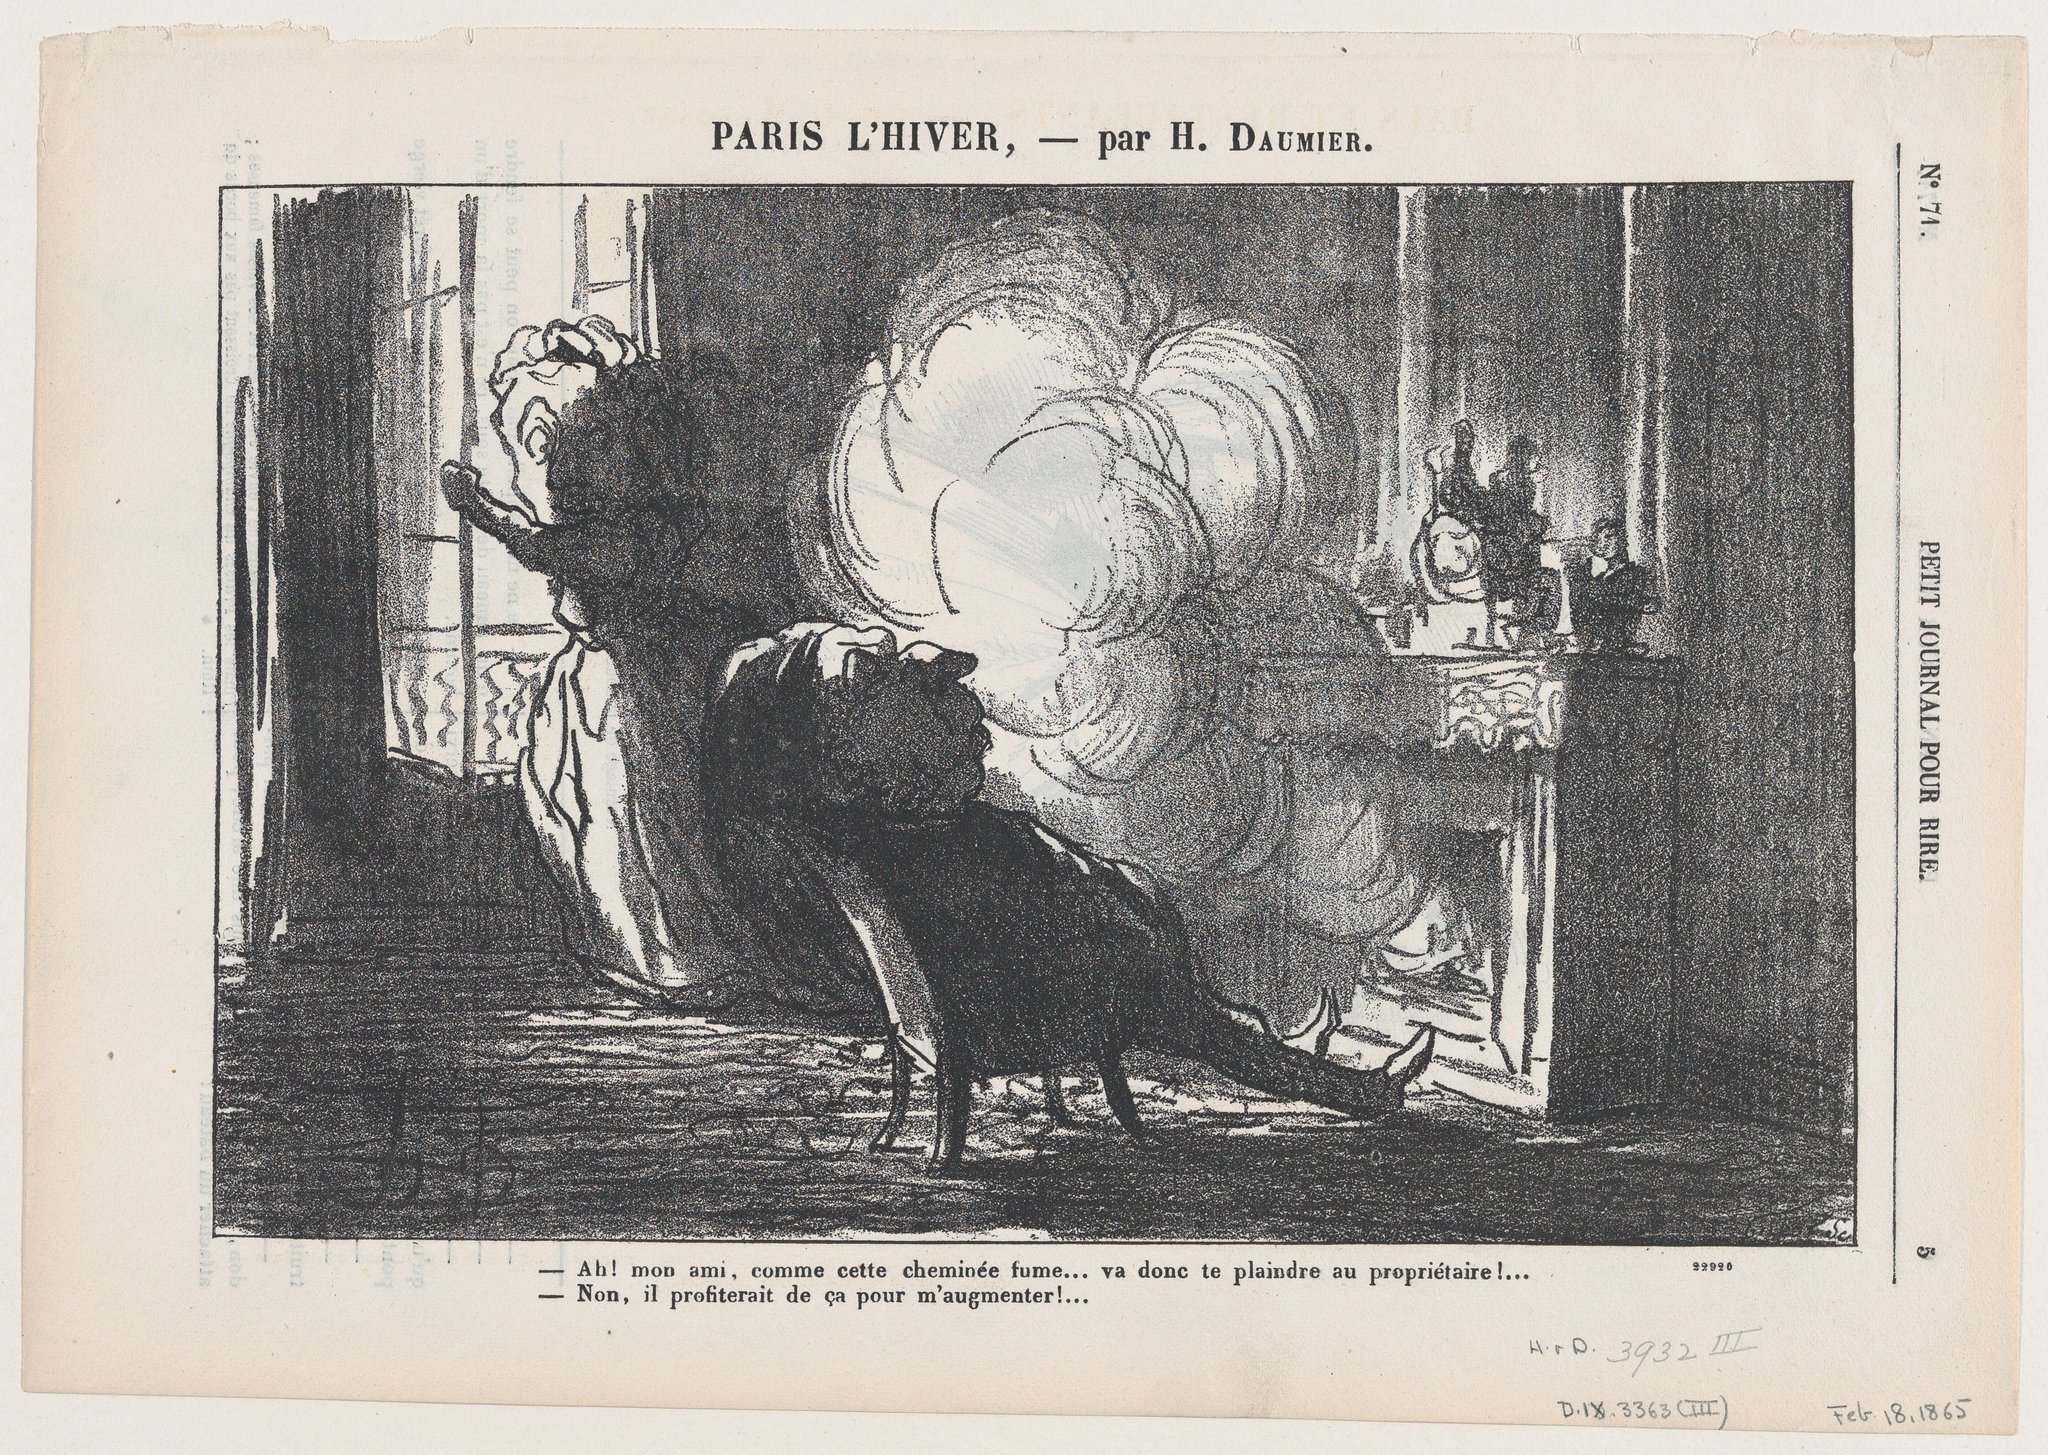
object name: print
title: Just look at that, my friend, how the fireplace is smoking..., from "Paris in Winter"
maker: honoré daumier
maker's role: artist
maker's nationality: french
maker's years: 1808-1879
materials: paper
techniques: lithograph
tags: fireplaces,men,women